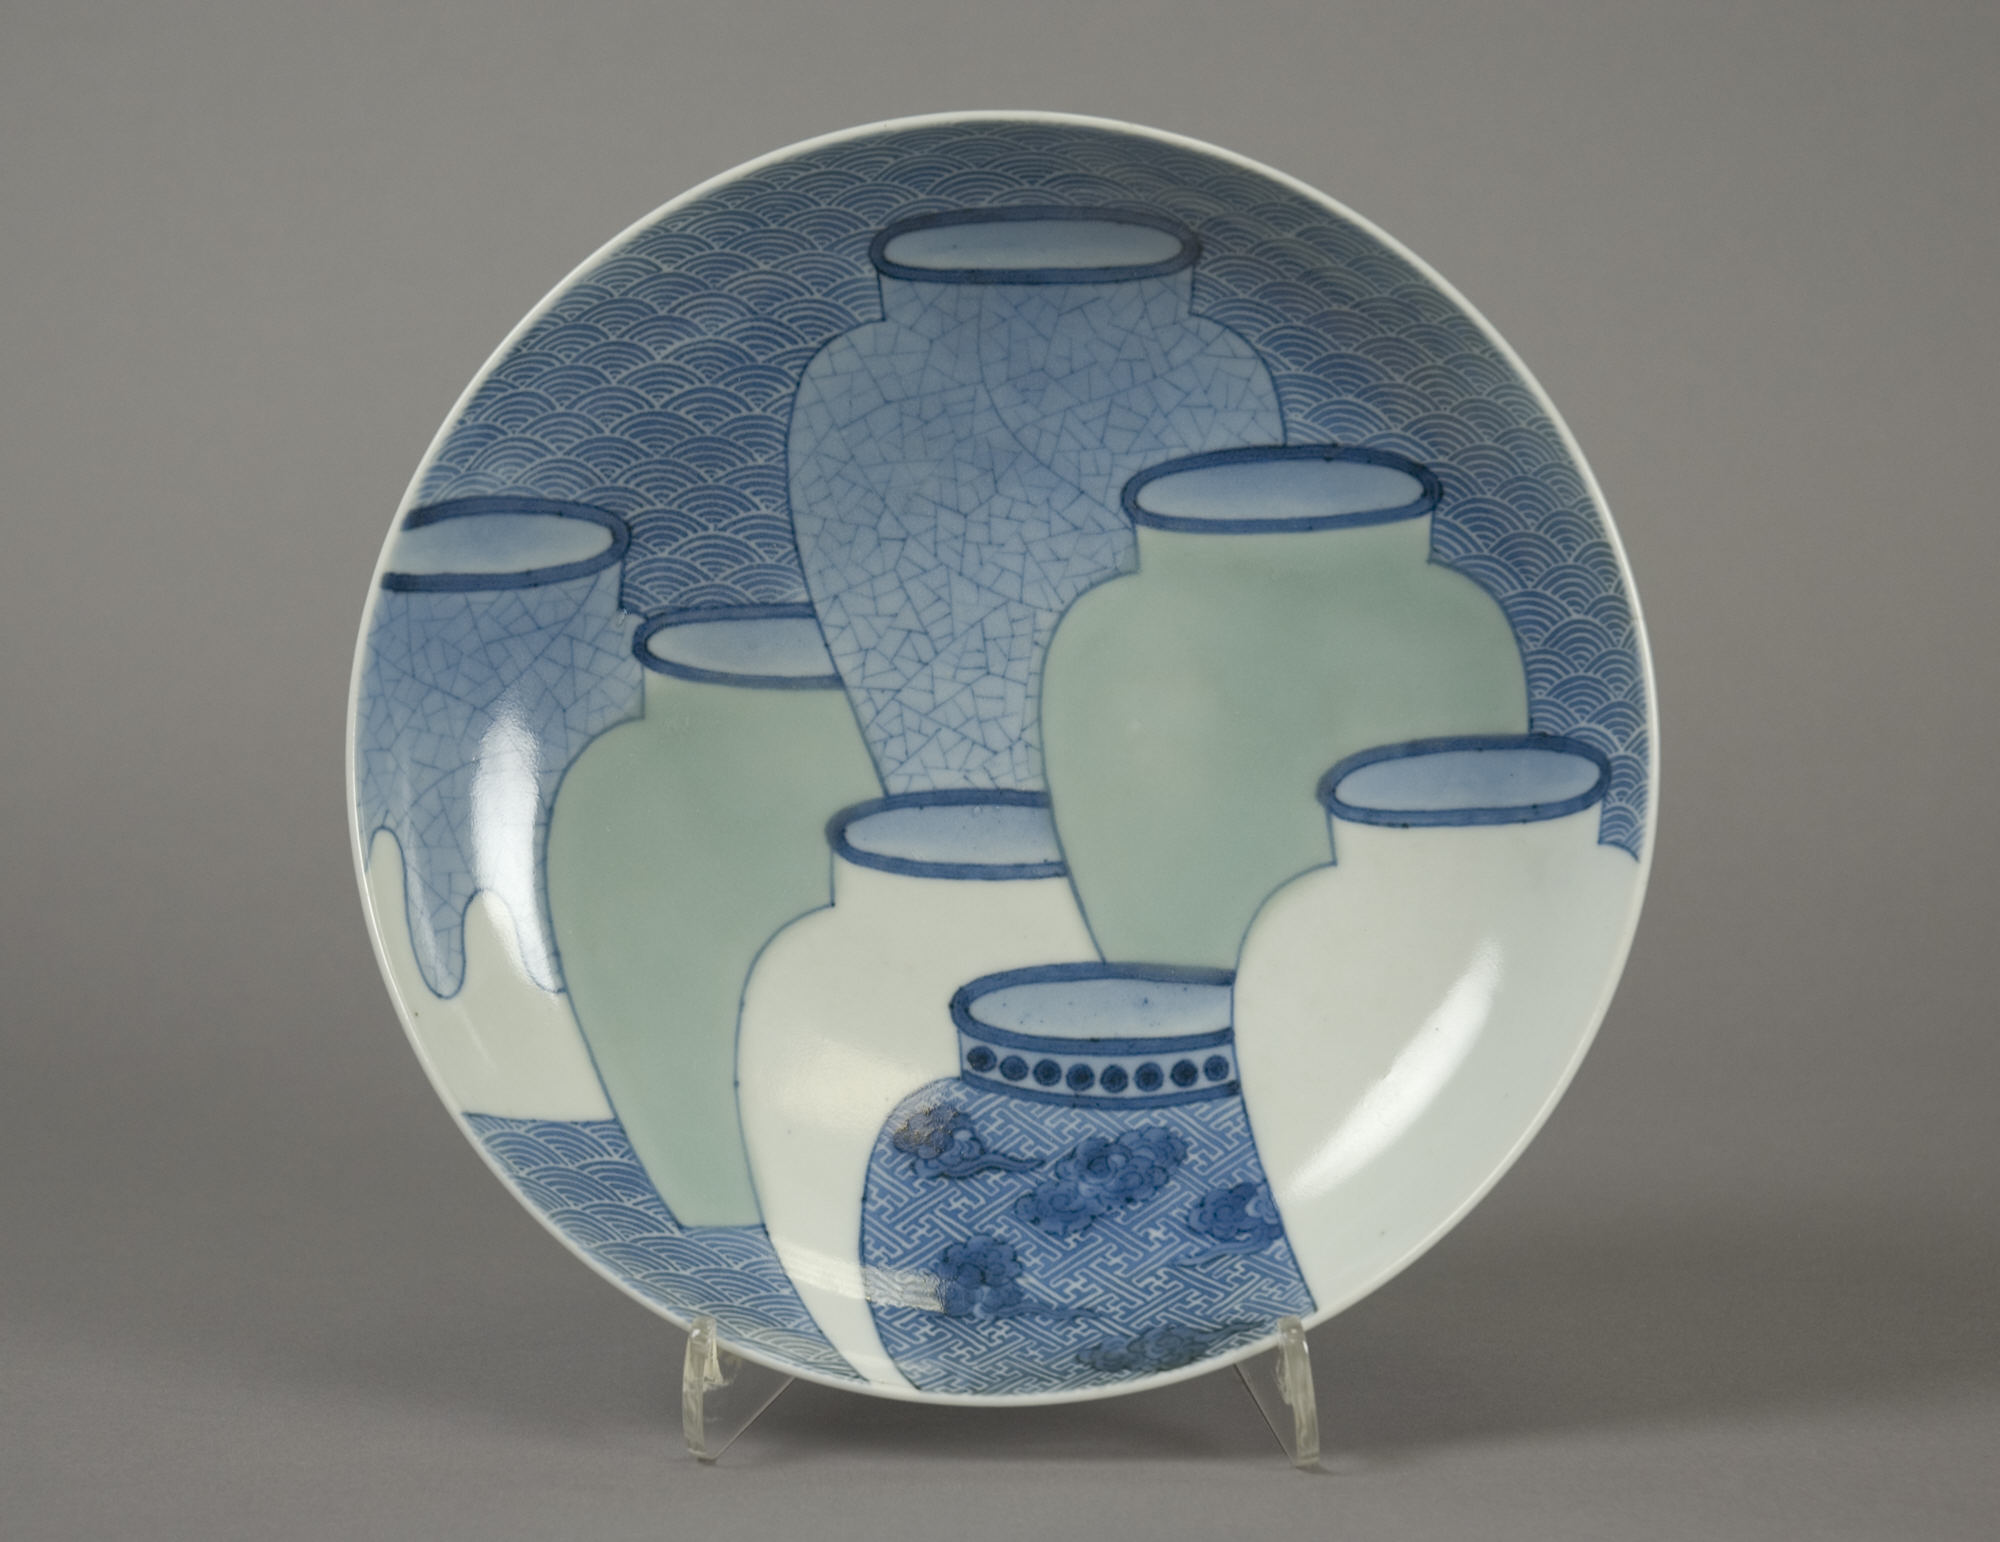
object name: dish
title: Dish with Design of Seven Jars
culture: japanese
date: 1700-1720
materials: ceramic glaze, glaze, porcelain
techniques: underglaze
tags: jars